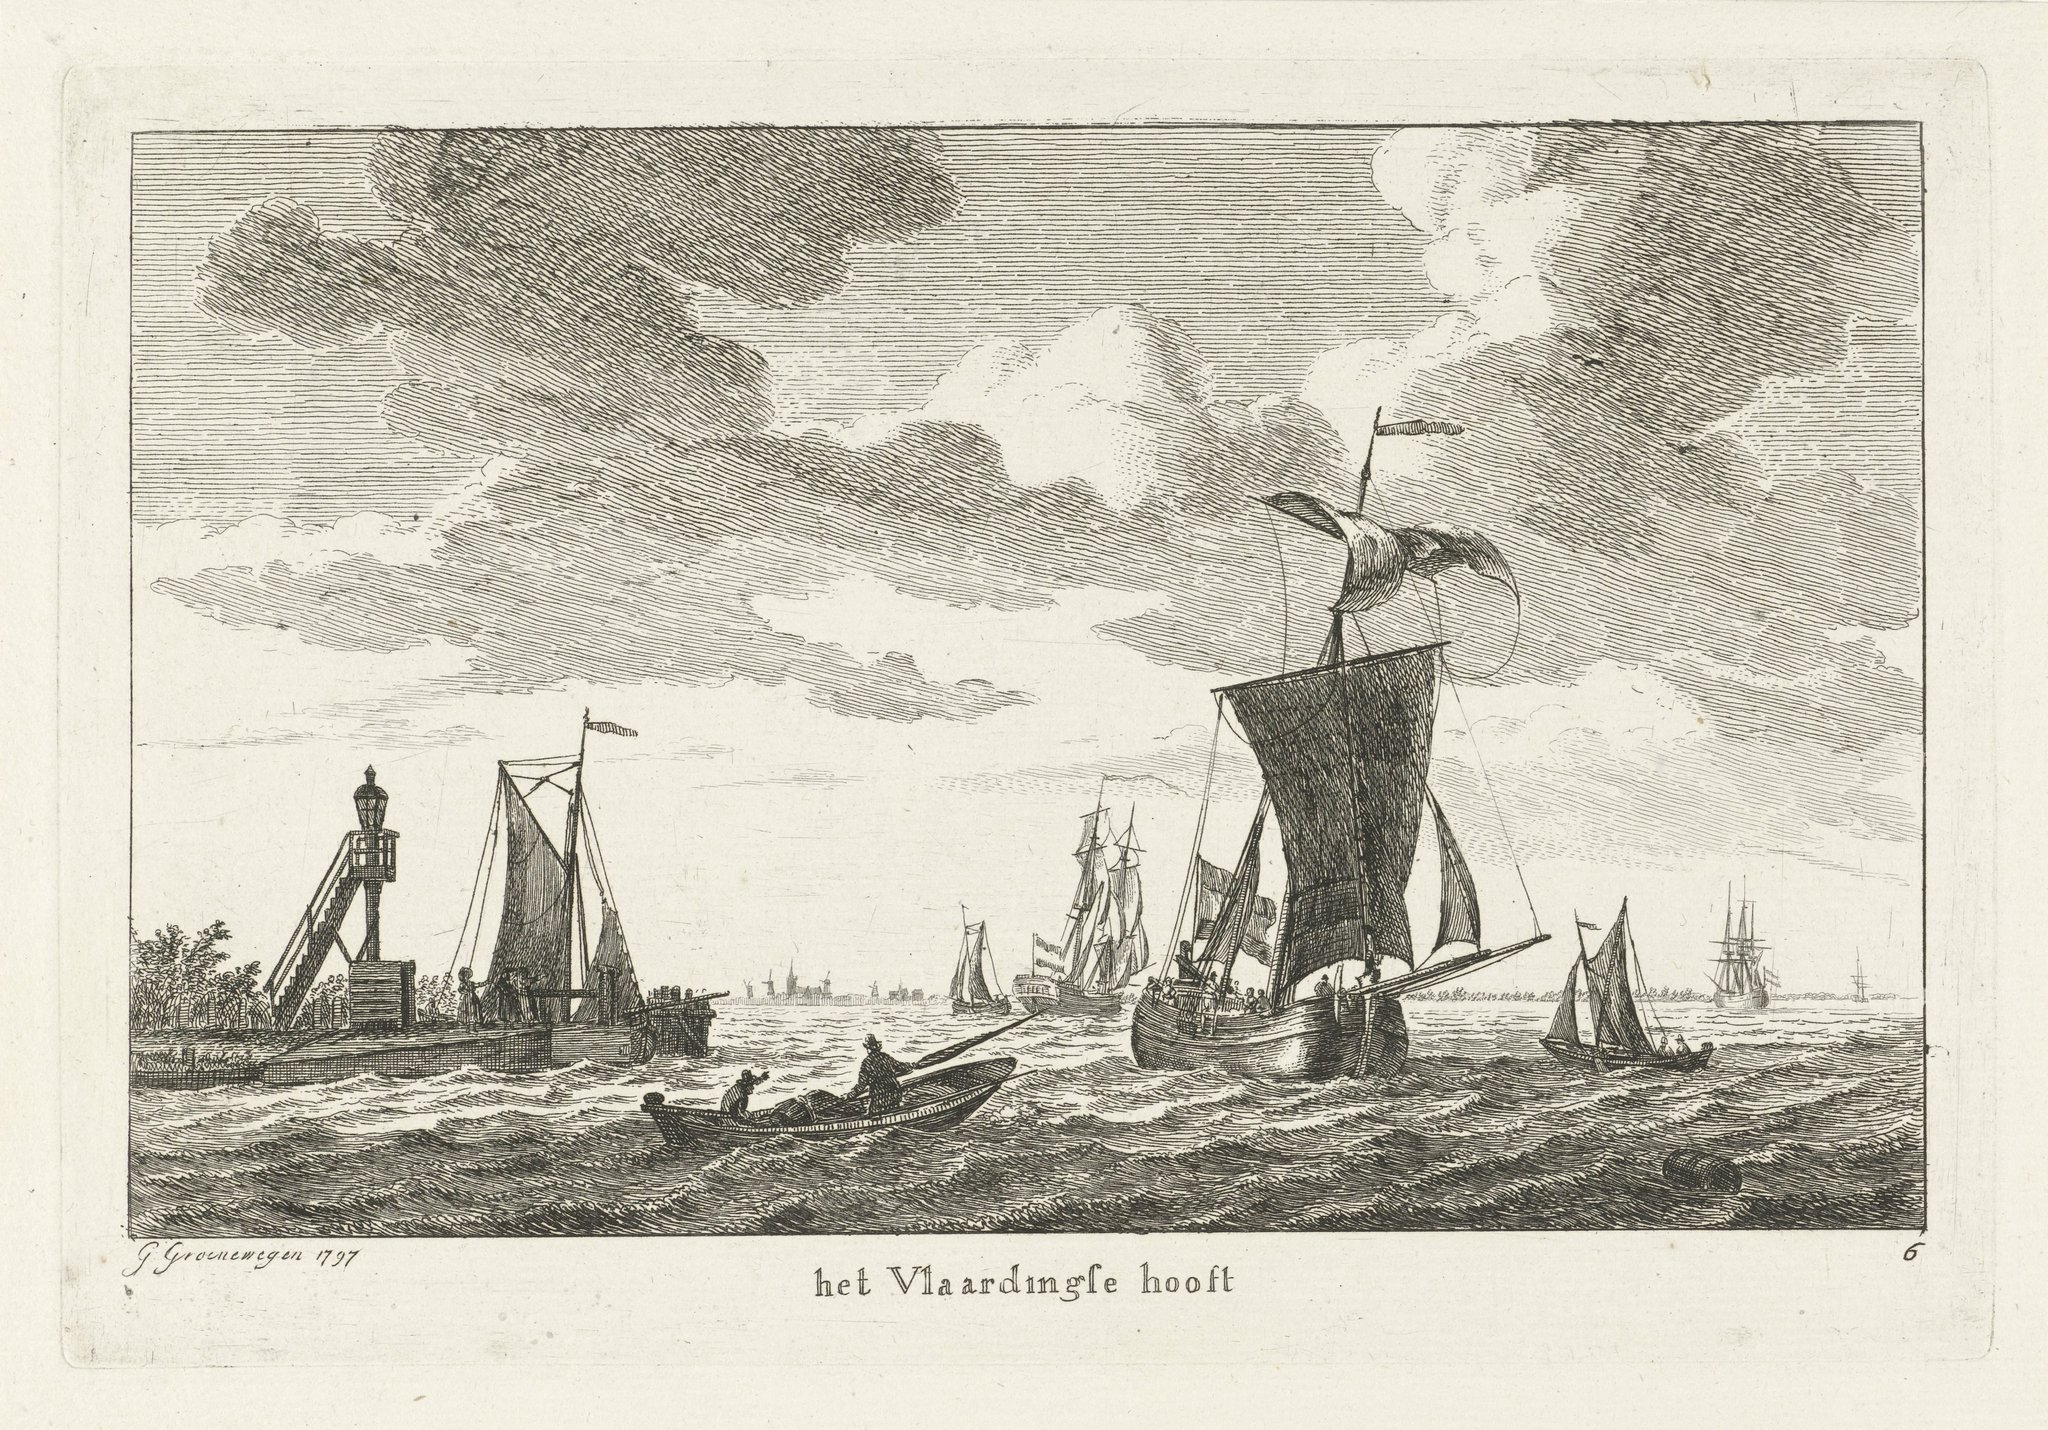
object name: print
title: Gezicht op het havenhoofd van Vlaardingen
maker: gerrit groenewegen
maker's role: draughtsman, print maker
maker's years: 1754-1826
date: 1797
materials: paper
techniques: etching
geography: rotterdam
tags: harbour, sailing-ship, sailing-boat, rowing-boat, canoe, etc.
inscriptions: collector's mark: Lugt 2228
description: Gezicht op de Maas en het havenhoofd van Vlaardingen (links). In het water een roeiboot en een aantal zeilschepen. Links op de achtergrond de contouren van Schiedam, rechts de zuidelijke Maasoever. Rechtsonder genummerd: 6. Deze prent maakt deel uit van een serie van zes prenten met Maasgezichten.